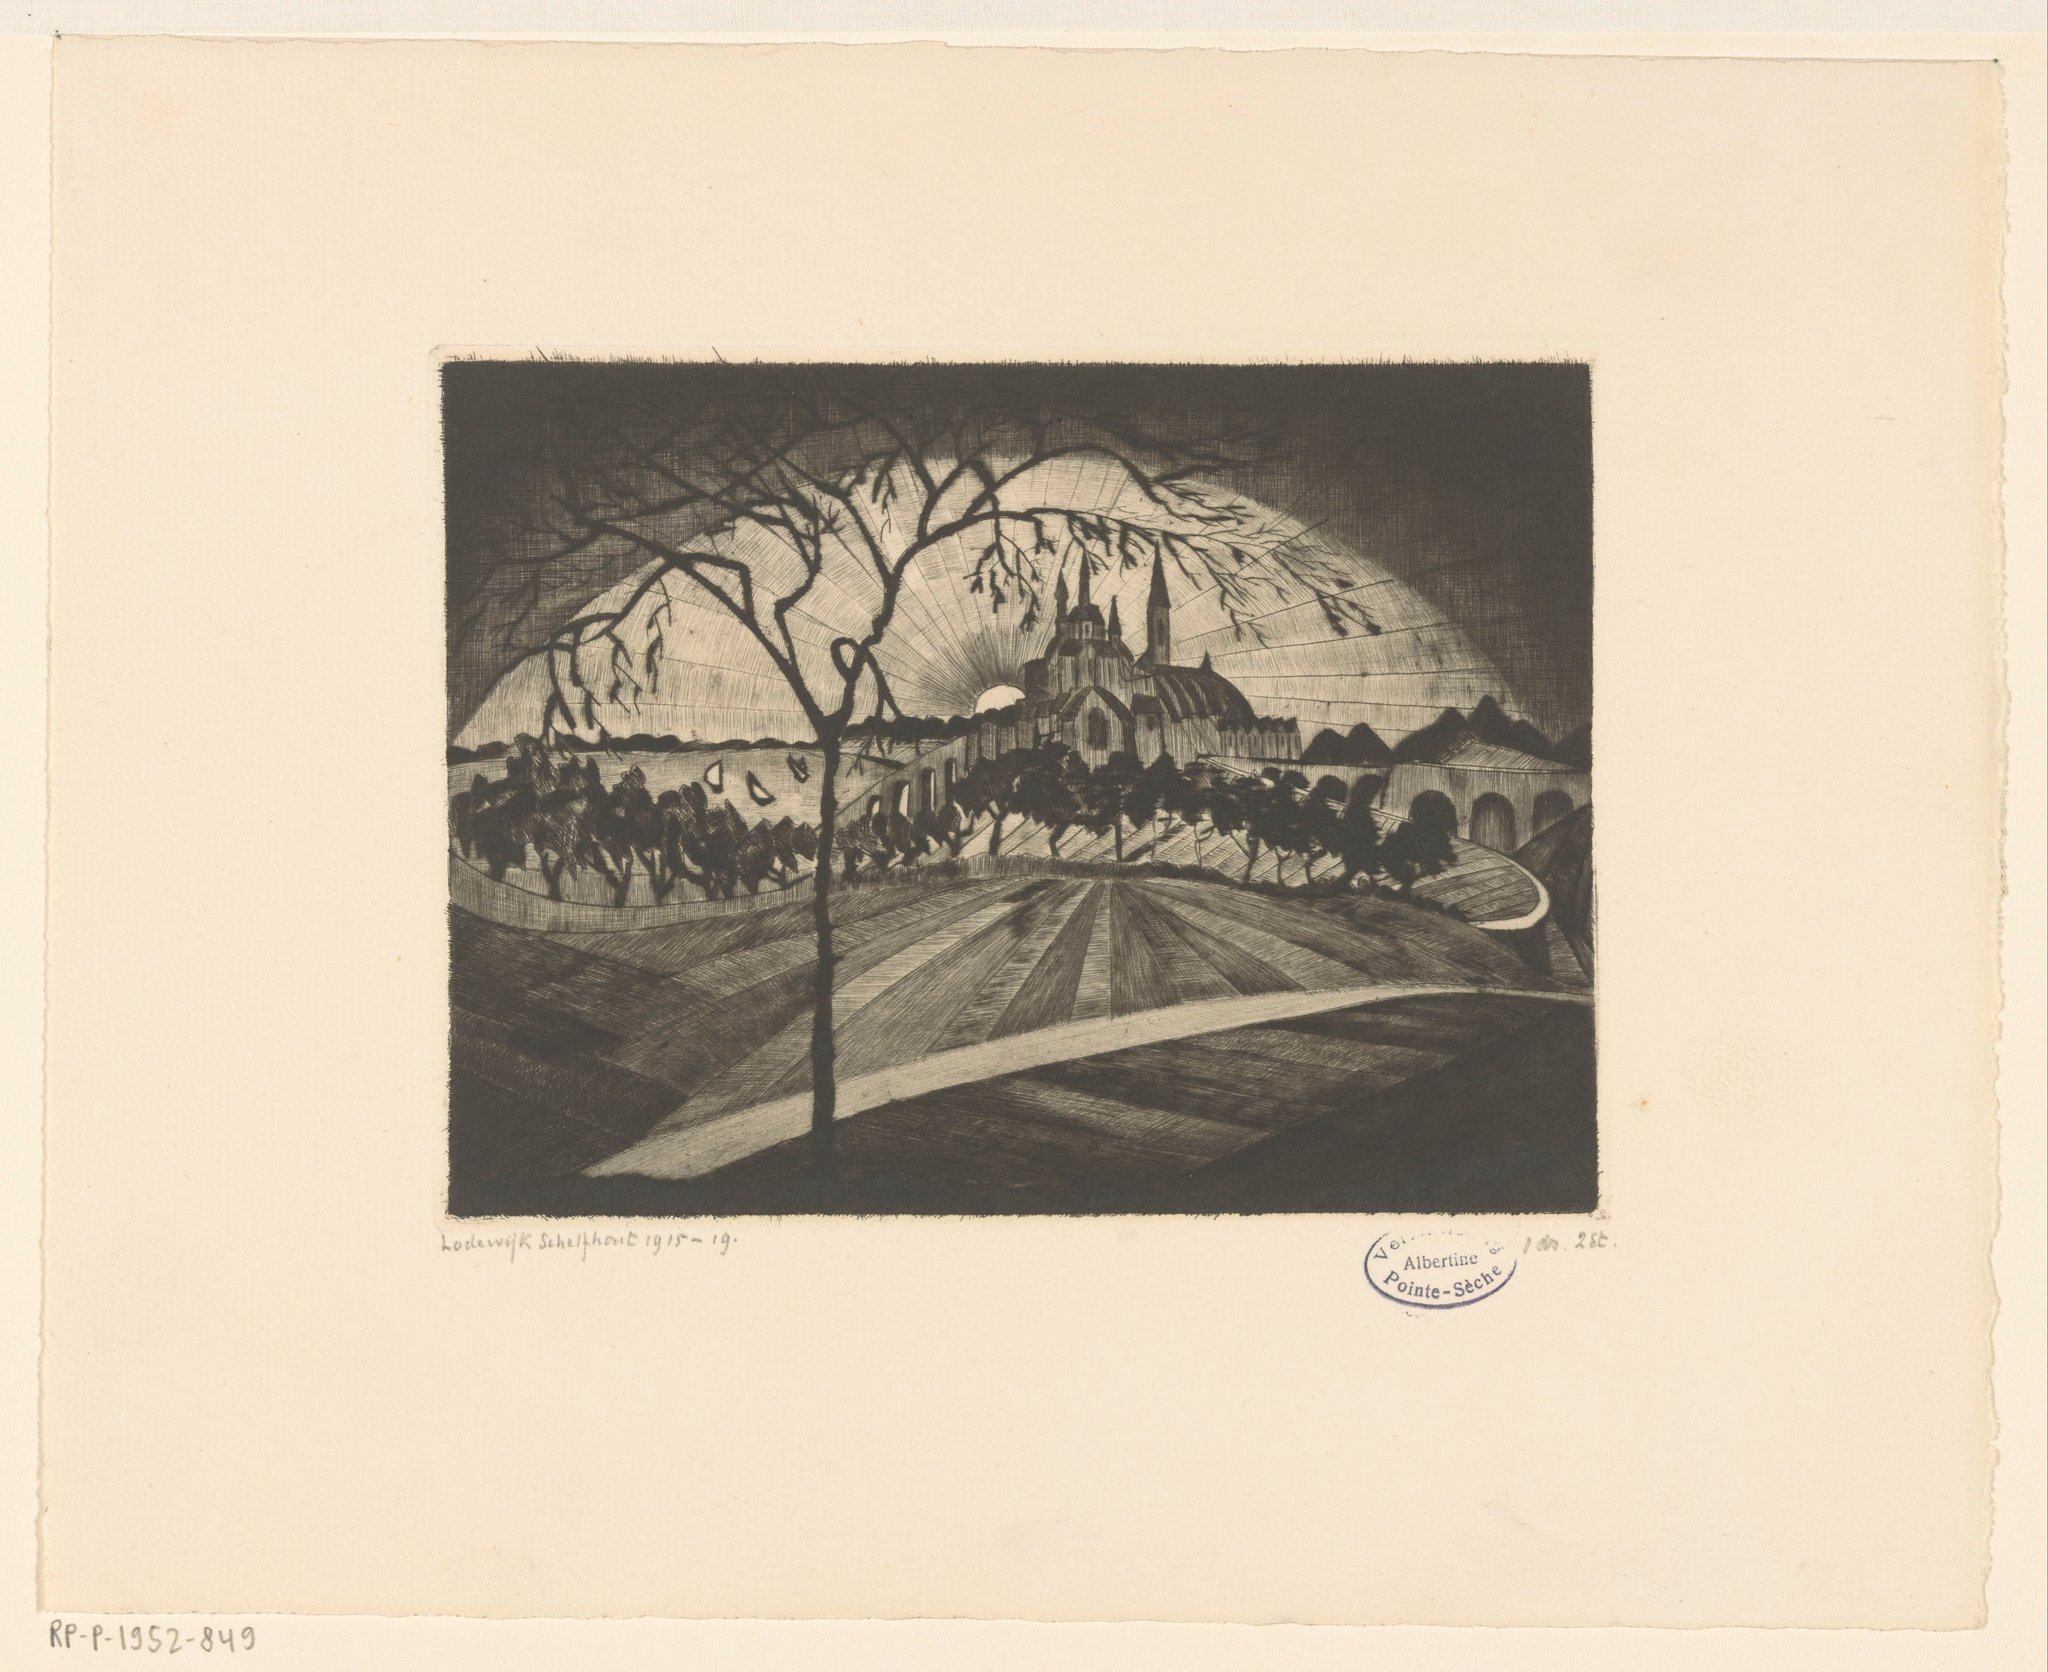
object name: print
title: Coucher de soleil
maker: lodewijk schelfhout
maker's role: draughtsman, print maker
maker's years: 1881-1943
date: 1915-1919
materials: paper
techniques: drypoint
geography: netherlands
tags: low hill country, sunset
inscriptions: collector's mark: Lugt 2228, collector's mark: Lugt 2760, collector's mark: Lugt 5i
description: Zonsondergang boven een heuvellandschap met een meer, een gebouw met meerdere torens en een boogbrug. Op de voorgrond een boom.